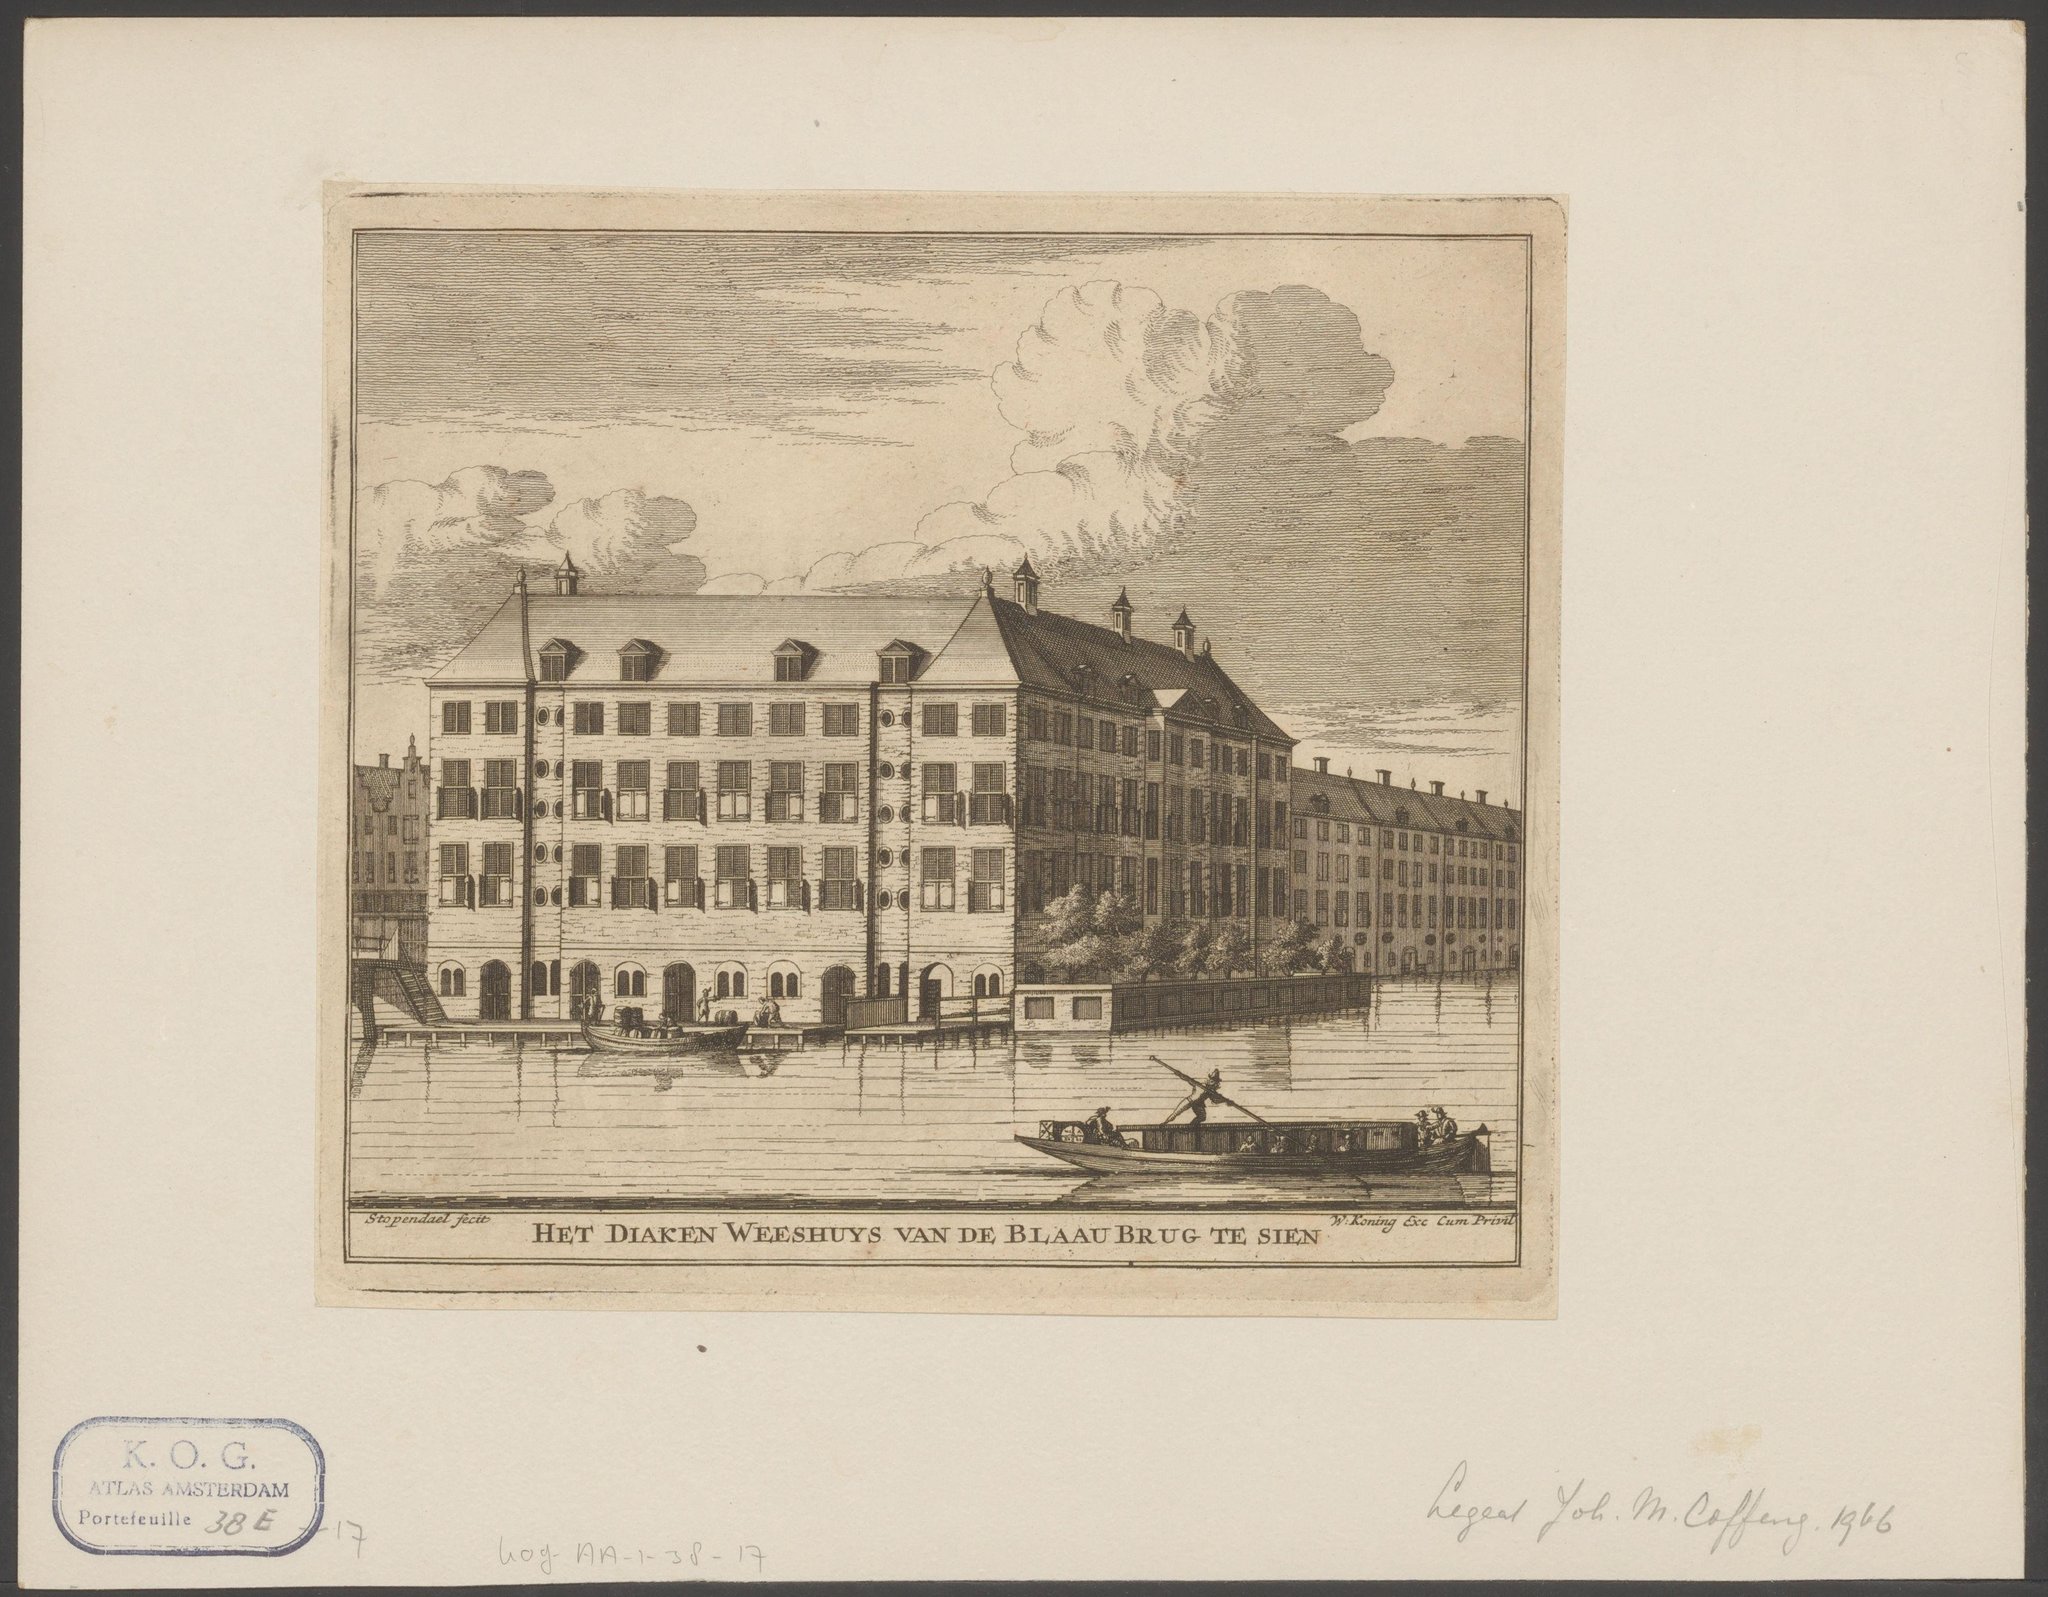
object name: print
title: Het Diaken Weeshuys van de Blaau Brug te sien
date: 1717-1726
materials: paper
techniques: engraving, etching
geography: amsterdam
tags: rowing-boat, canoe, etc., orphanage, canals, waters (in city) (+ city(-scape) with figures, staffage)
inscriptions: collector's mark: Lugt 1641b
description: Tweede staat van prent (met Franse titel) ook gebruikt in: Description de la fameuse ville d'Amsterdam (...) / Afbeeldinge van de wydt-vermaarde stadt Amsterdam (...). Amsterdam: Hendrik de Leth, [ca. 1740]. Derde staat van prent (rechtsboven gemerkt Pag. 186) ook gebruikt in: Le guide, ou nouvelle description d'Amsterdam (…). Amsterdam: Covens & Mortier & Covens Jr., 1772.